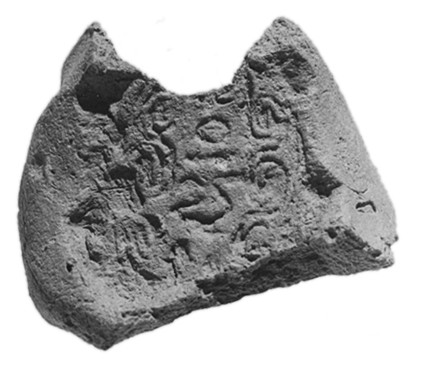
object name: sealing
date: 2030-1640 BCE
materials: clay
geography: egypt